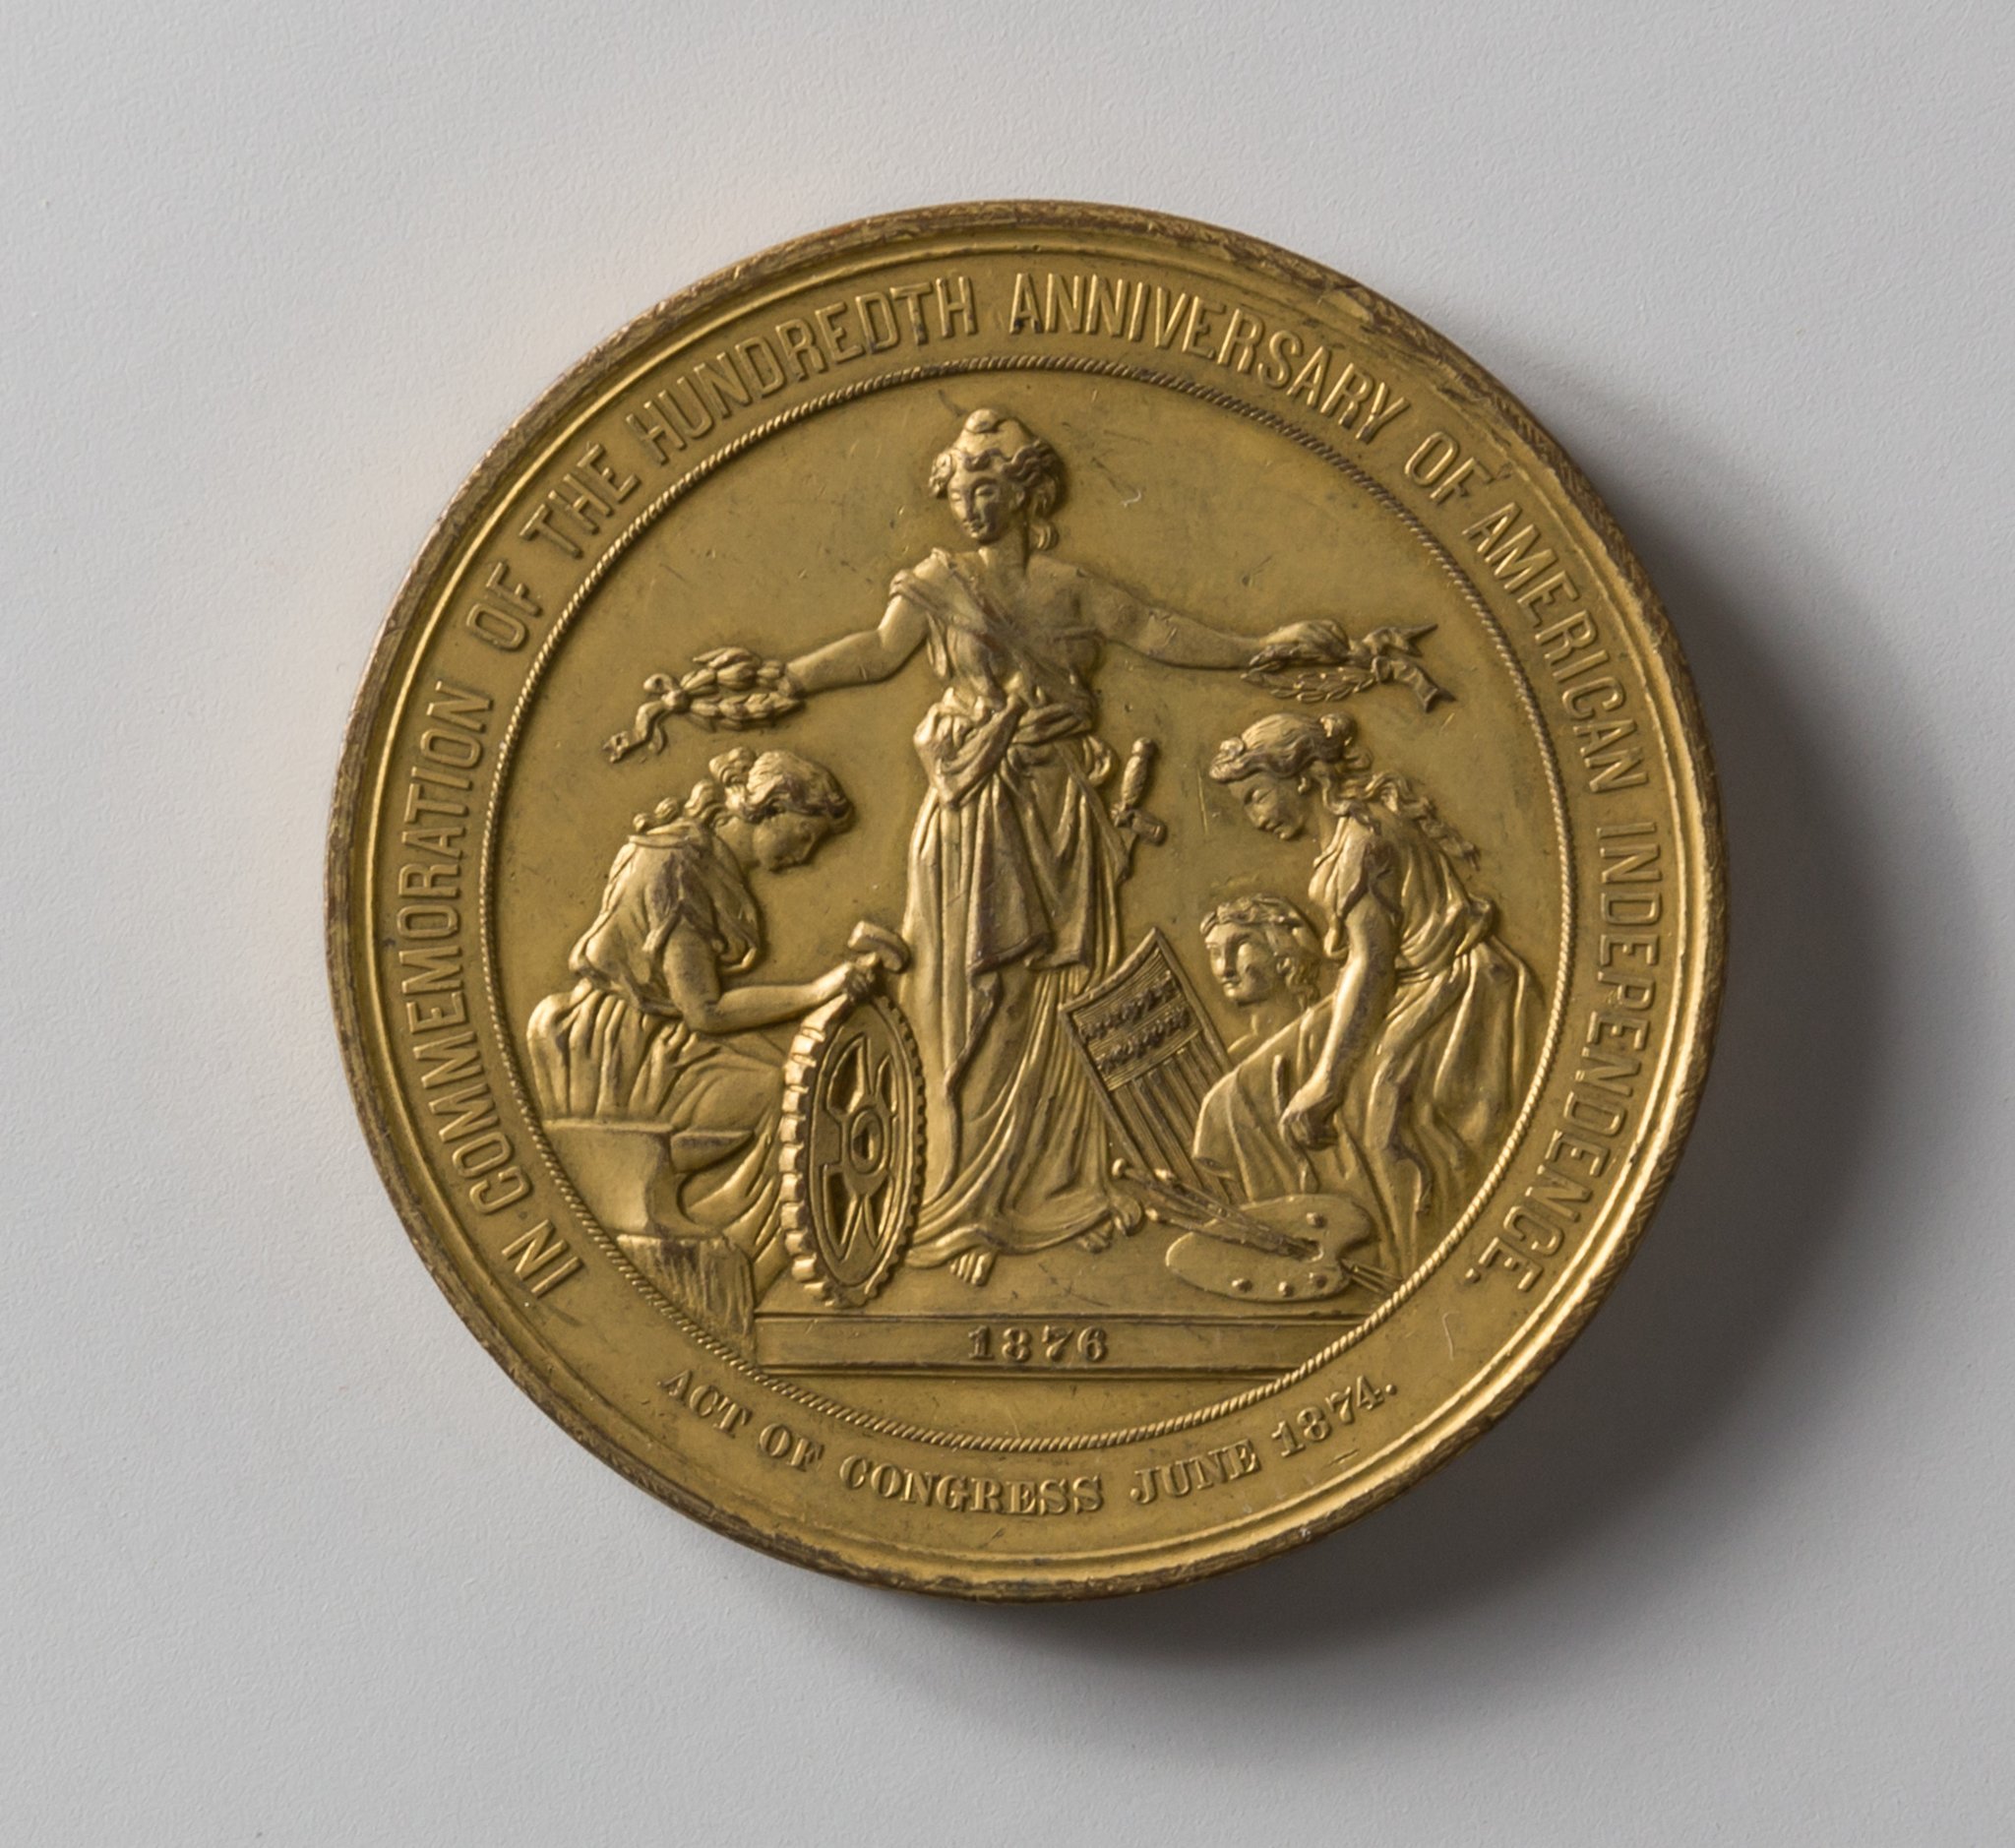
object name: medal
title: Philadelphia Centennial Exhibition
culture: american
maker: william barber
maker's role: artist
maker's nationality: american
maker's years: 1807-1879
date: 1876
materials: bronze, gold leaf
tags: women